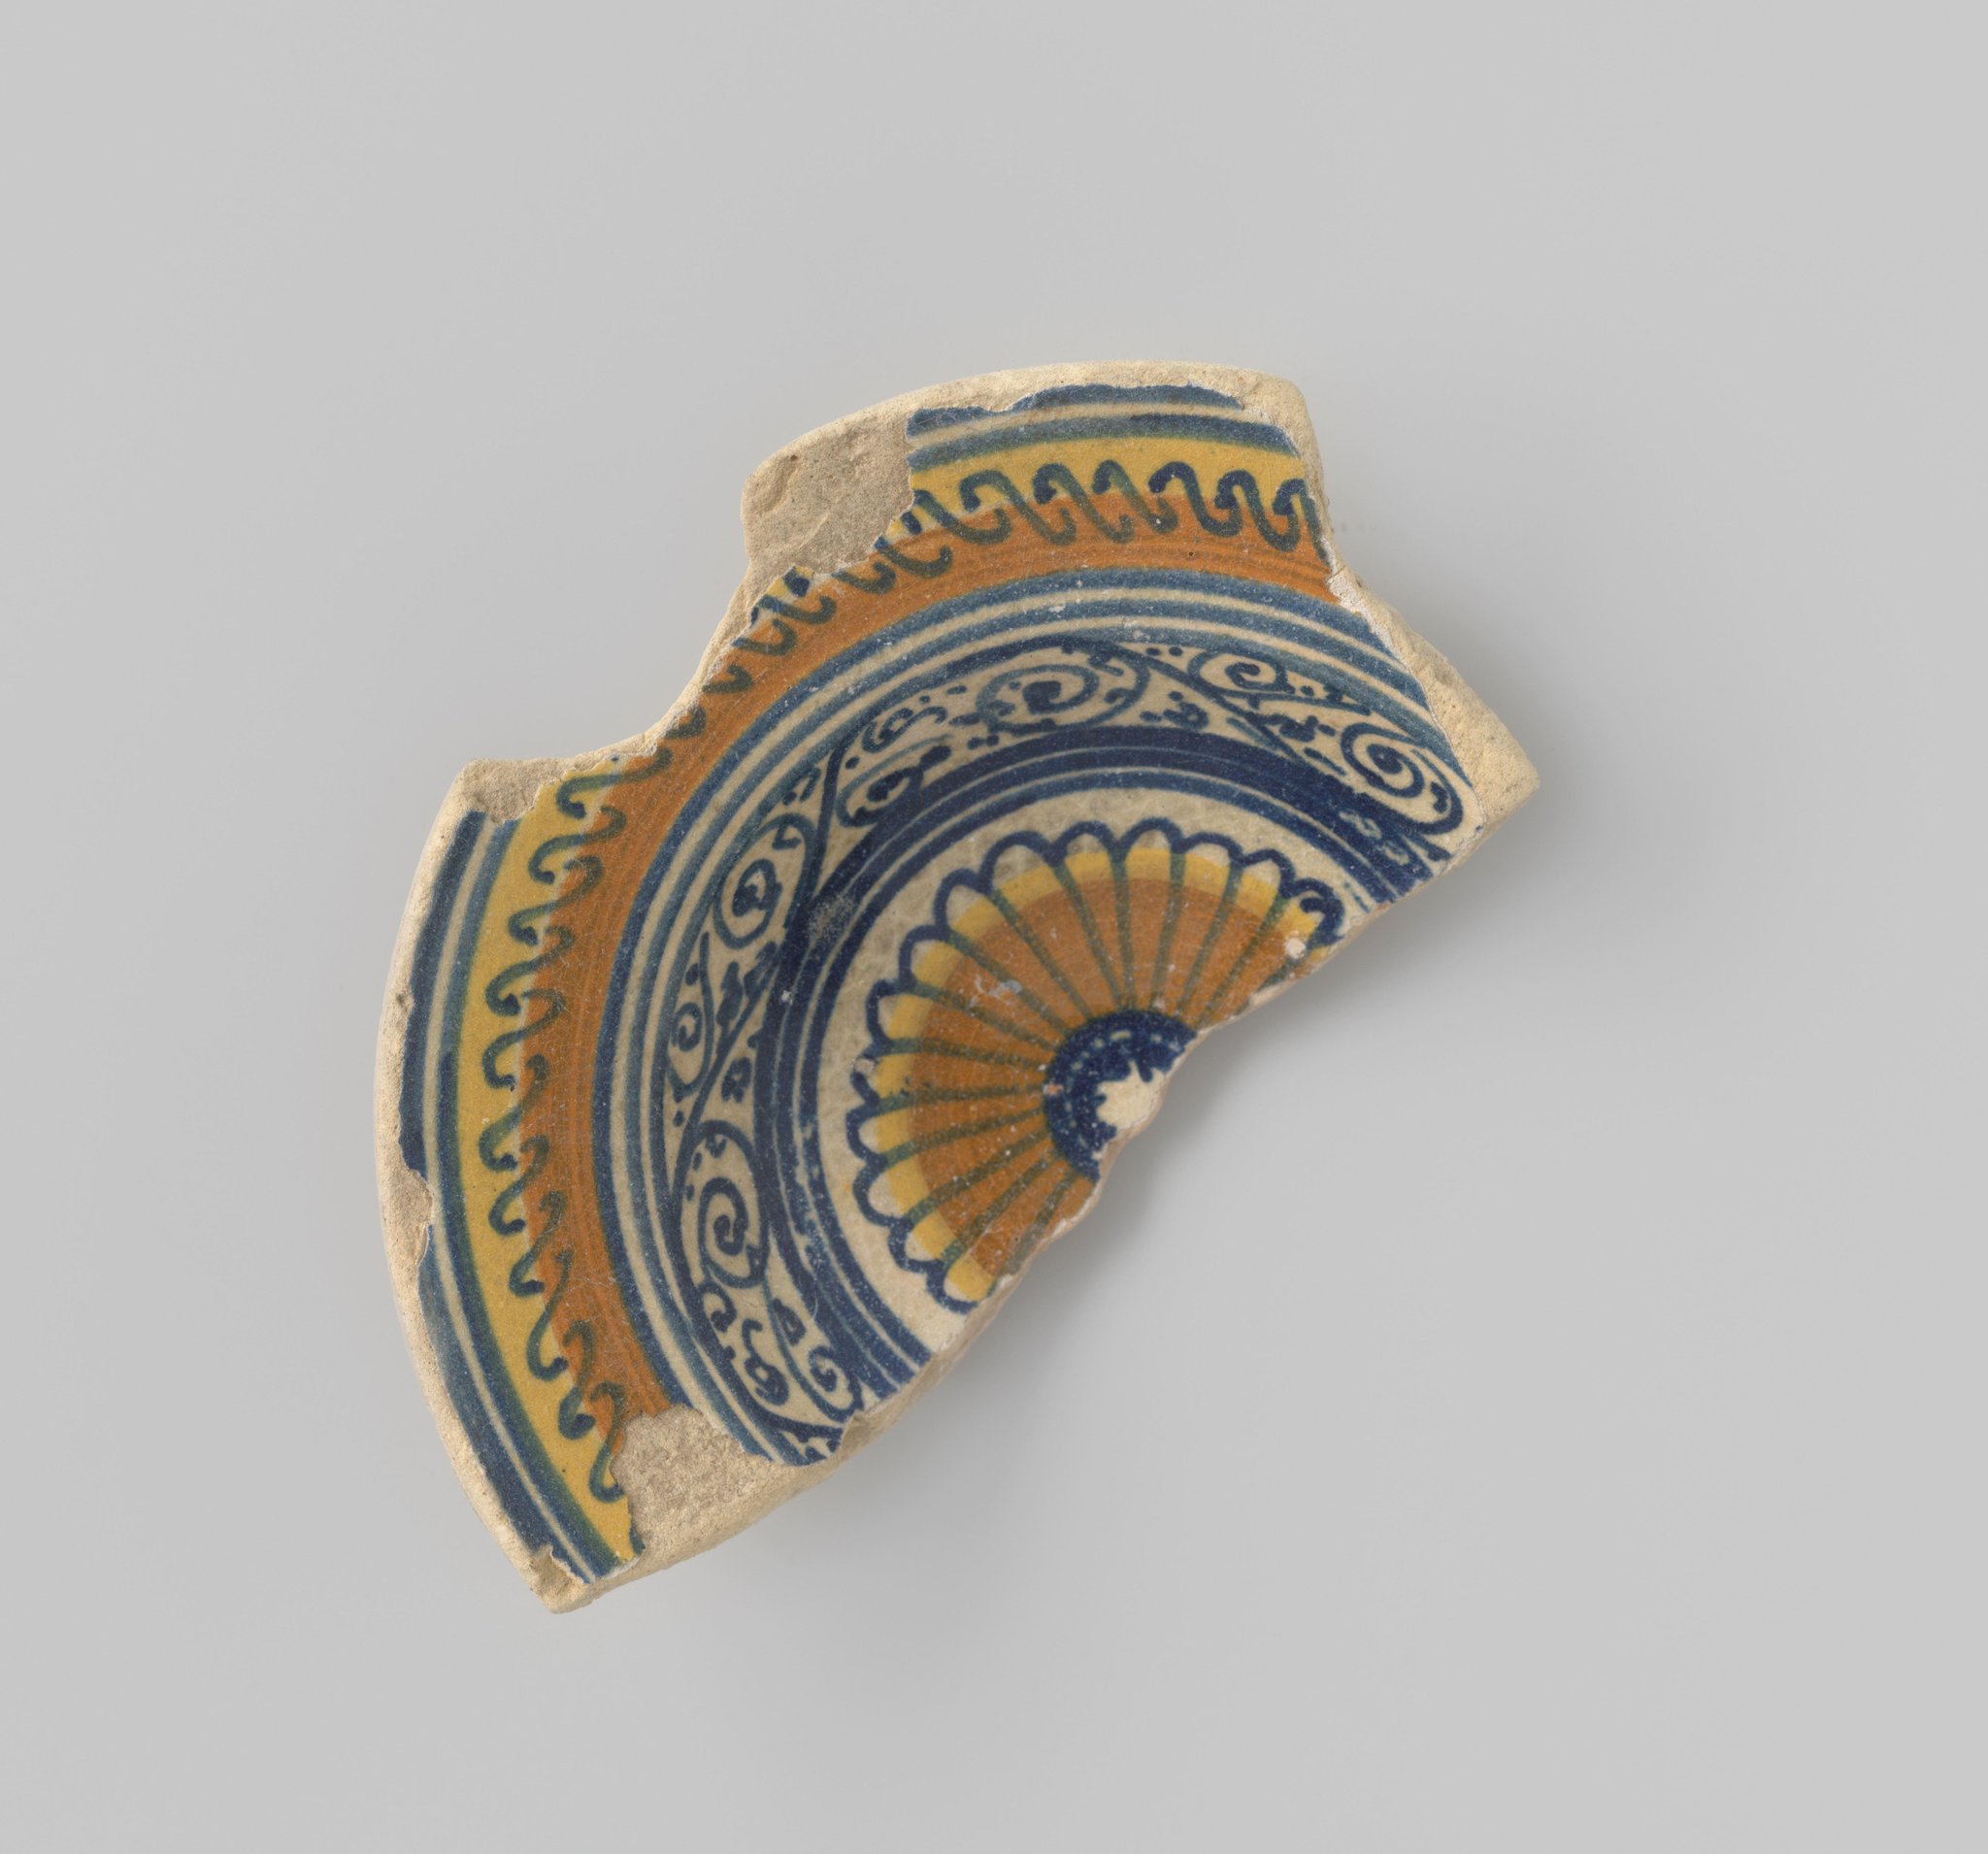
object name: sherd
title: Schotelscherf van witbakkend aardewerk, voorzien van wit glazuur aan de bovenzijde, waarop een een gestileerde bloem in blauw, geel en oranje geschilderd is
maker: Anonymous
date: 1500-1699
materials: earthenware, glaze